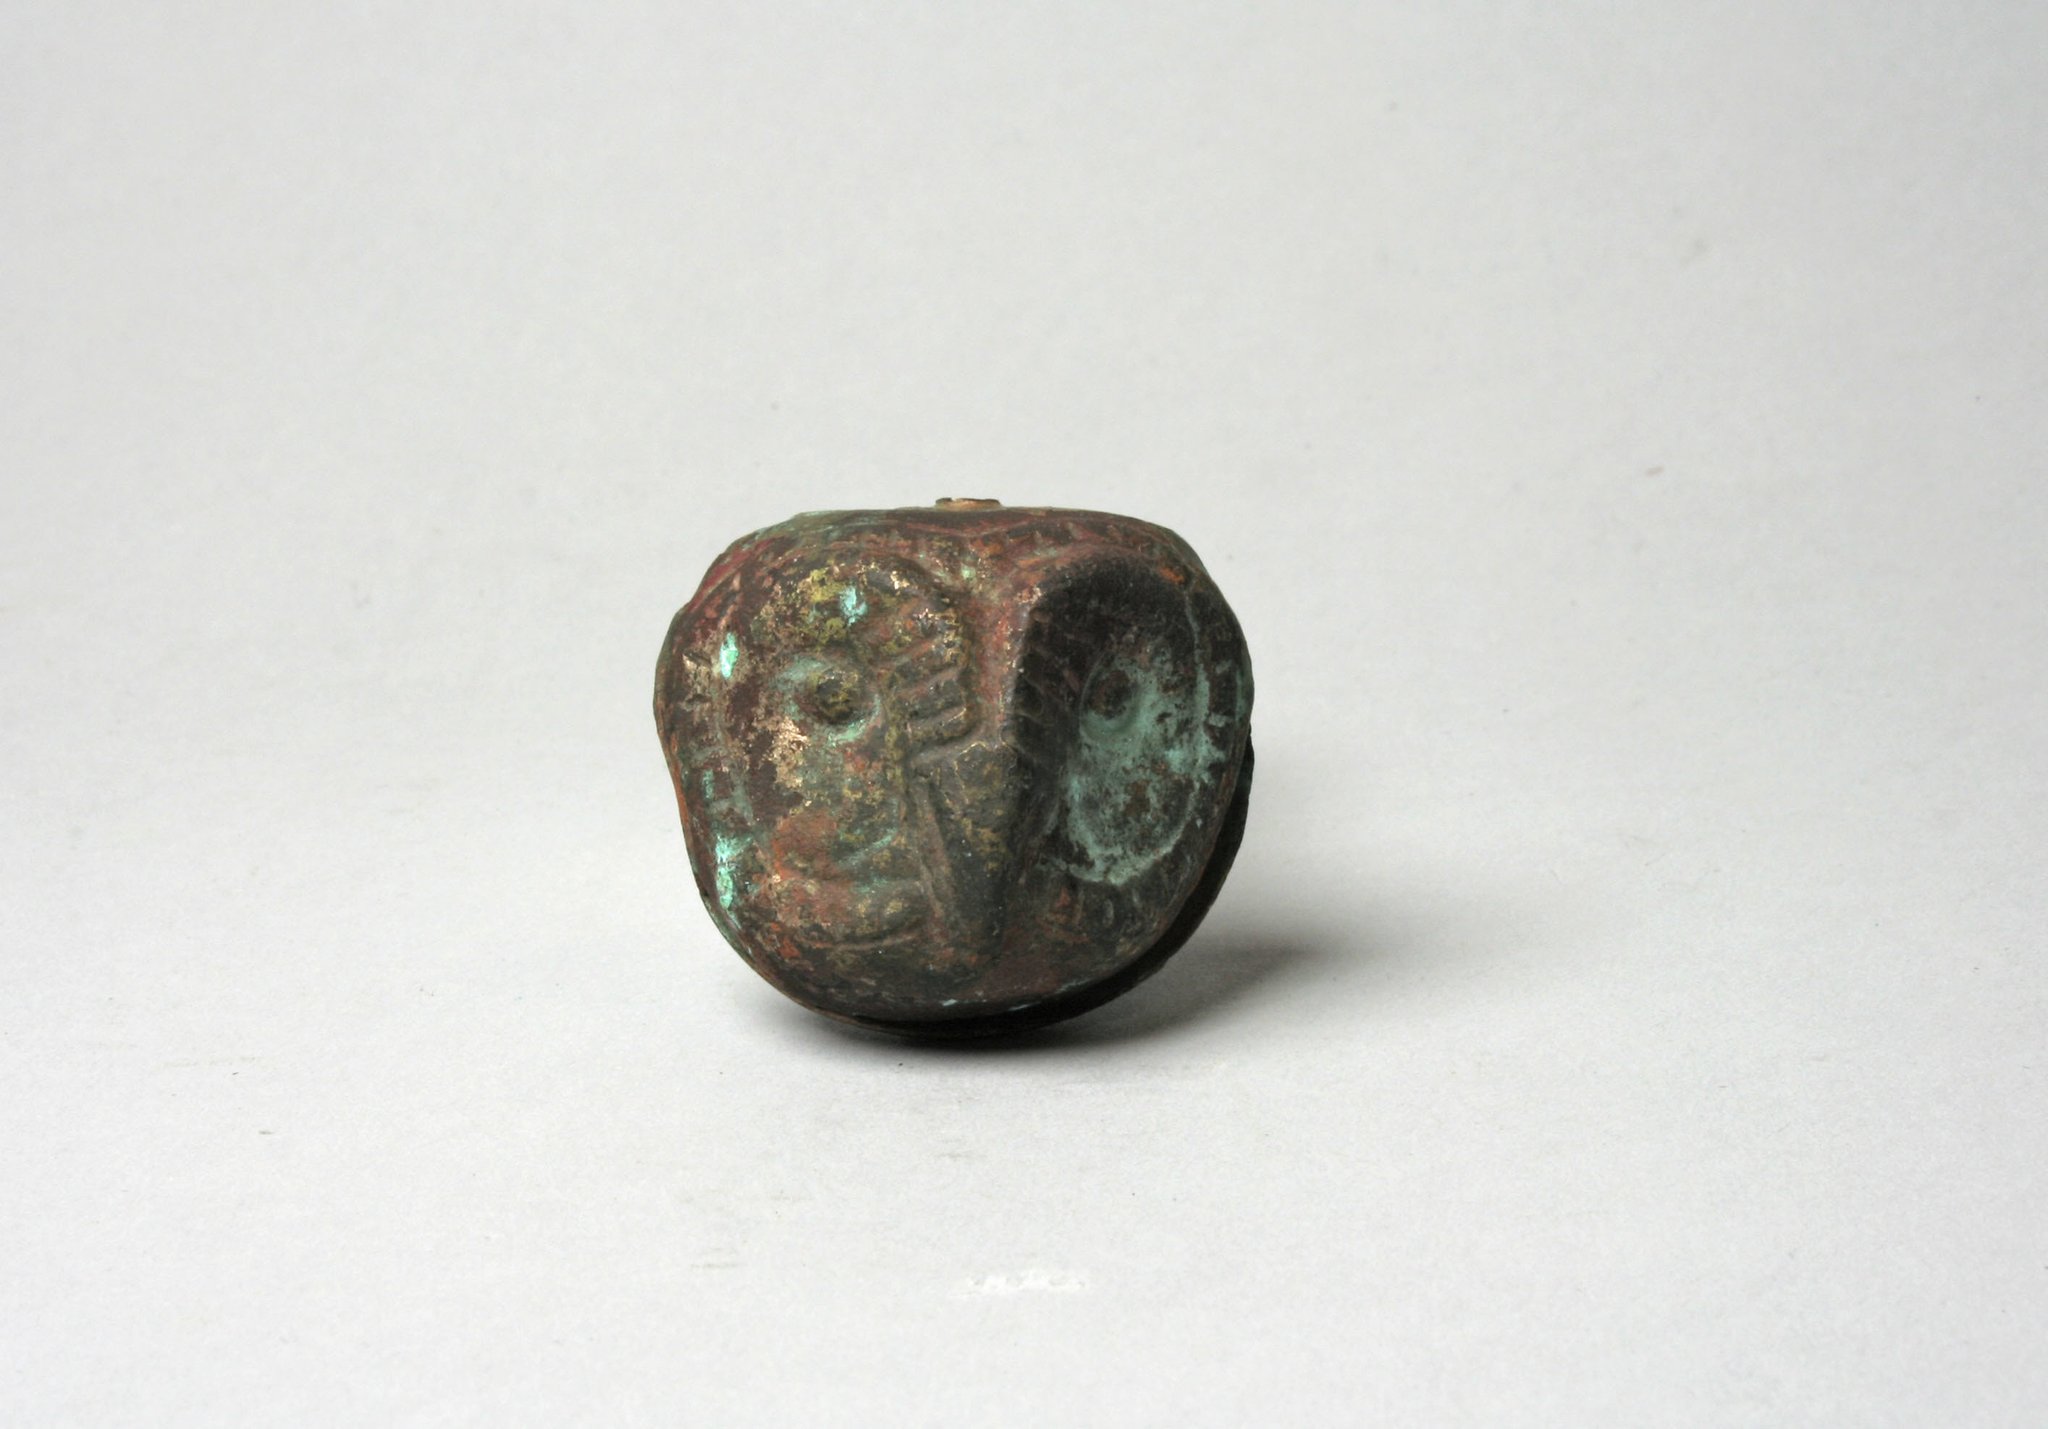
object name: ornament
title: Owl Bell Ornament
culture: moche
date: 501-700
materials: gilt copper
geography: peru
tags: owls